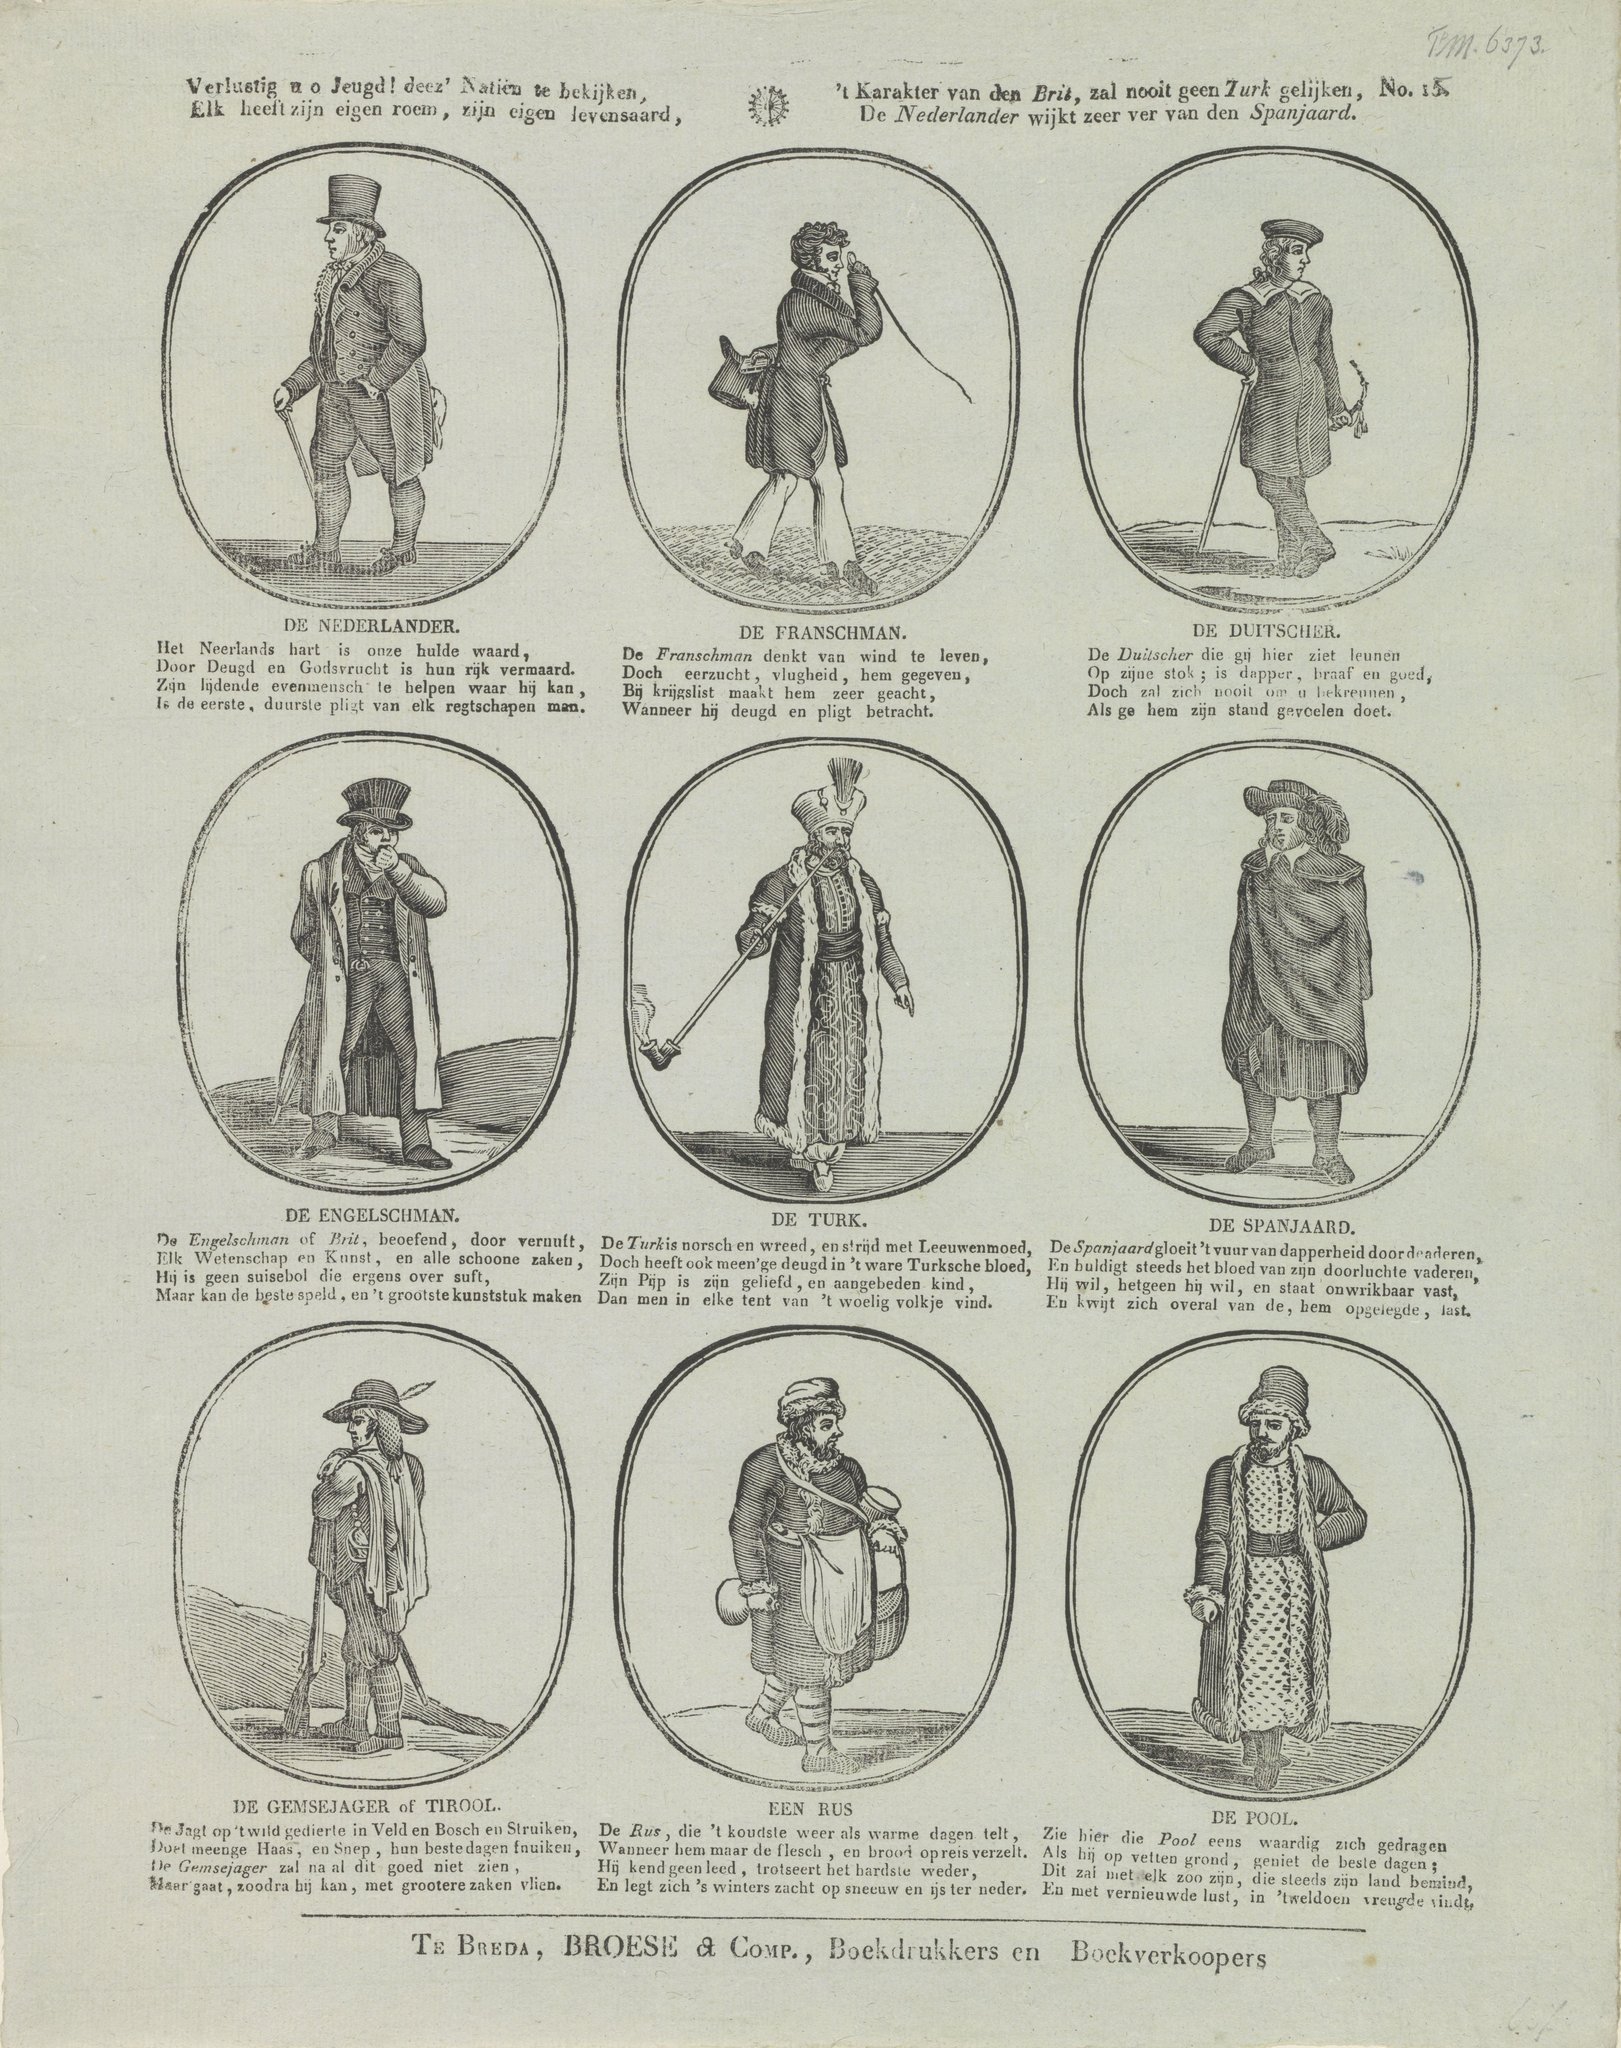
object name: popular print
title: Verlustig u o jeugd! deez' natiën te bekijken, / Elk heeft zijn eigen roem, zijn eigen levensaard, / 't karakter van den Brit, zal nooit geen Turk gelijken, / De Nederlander wijkt zeer ver van den Spanjaard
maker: Anonymous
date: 1828-1853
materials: paper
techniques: letterpress printing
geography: breda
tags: human types; peoples and nationalities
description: Blad met 9 voorstellingen van mensen van verschillende nationaliteiten, zoals een Fransman, een Turk en een Rus. Onder elke voorstelling een titel en een vierregelig vers. Genummerd rechtsboven: No. 15.